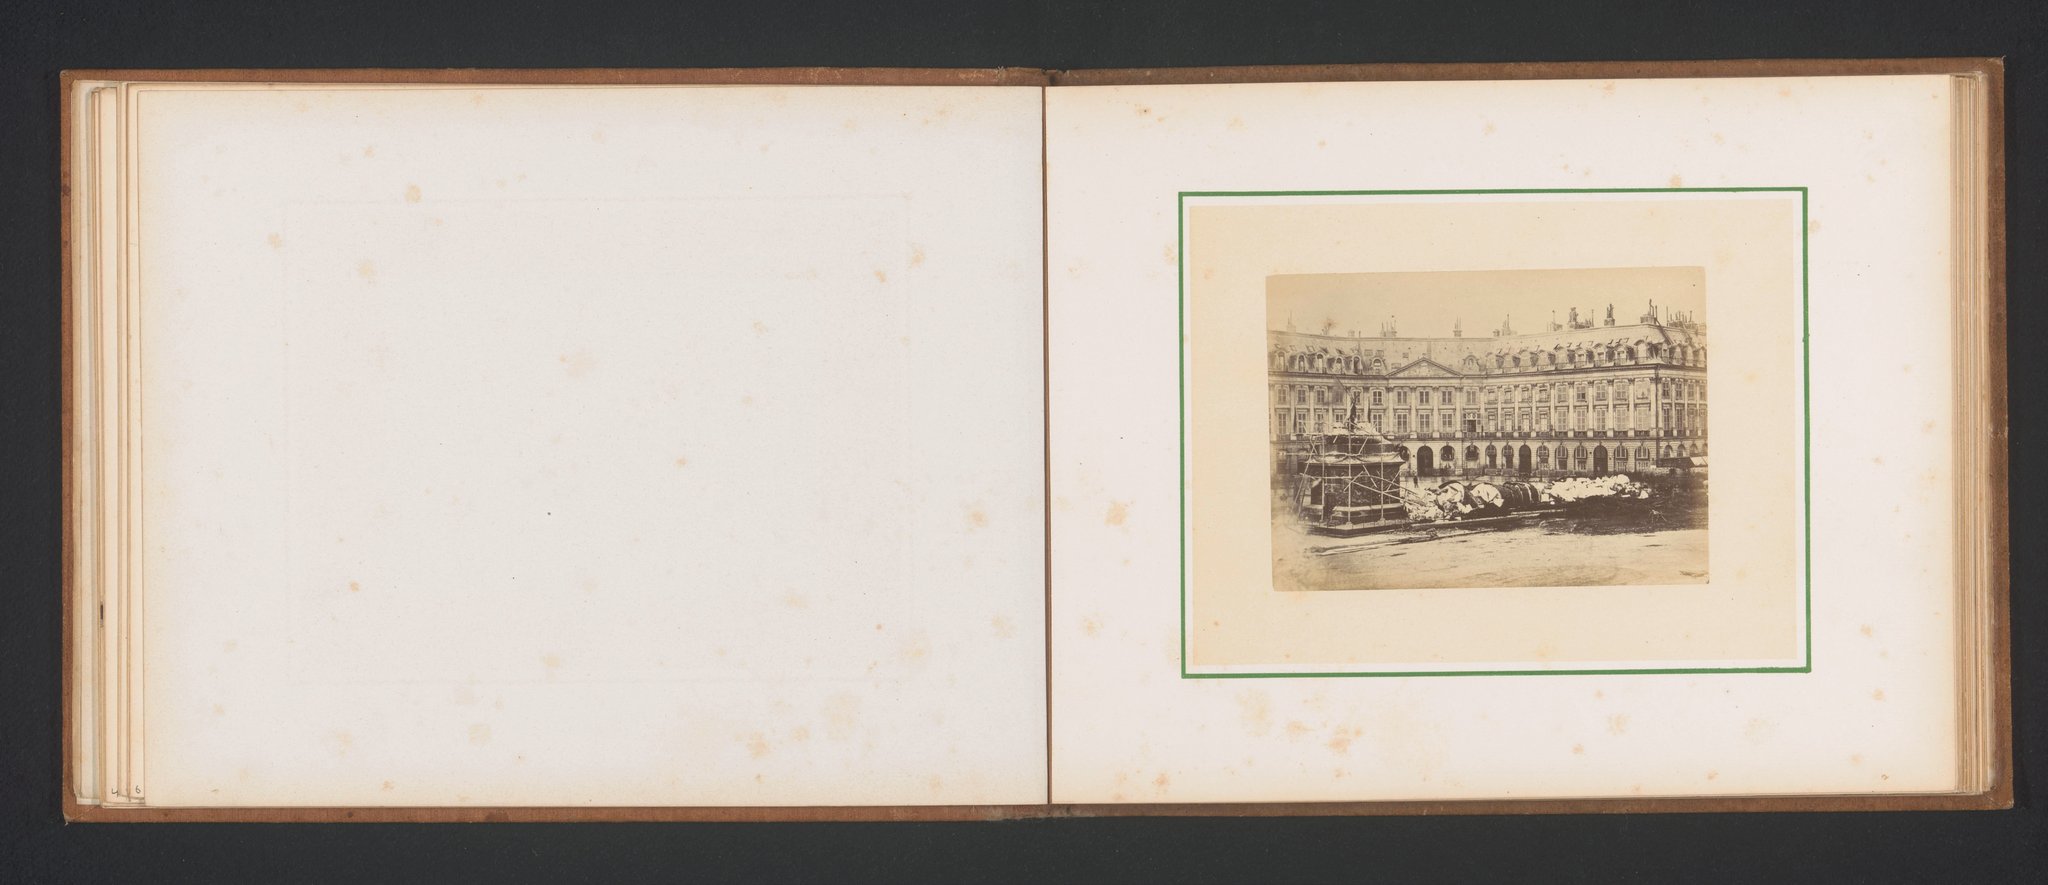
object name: page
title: Gezicht op de resten van de Colonne Vendôme in Parijs na de Commune van Parijs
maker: p. loubère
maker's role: fotograaf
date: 1871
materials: photographic support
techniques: albumen print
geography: paris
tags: ruin of a building ~ architecture, triumphal column with helical friezes